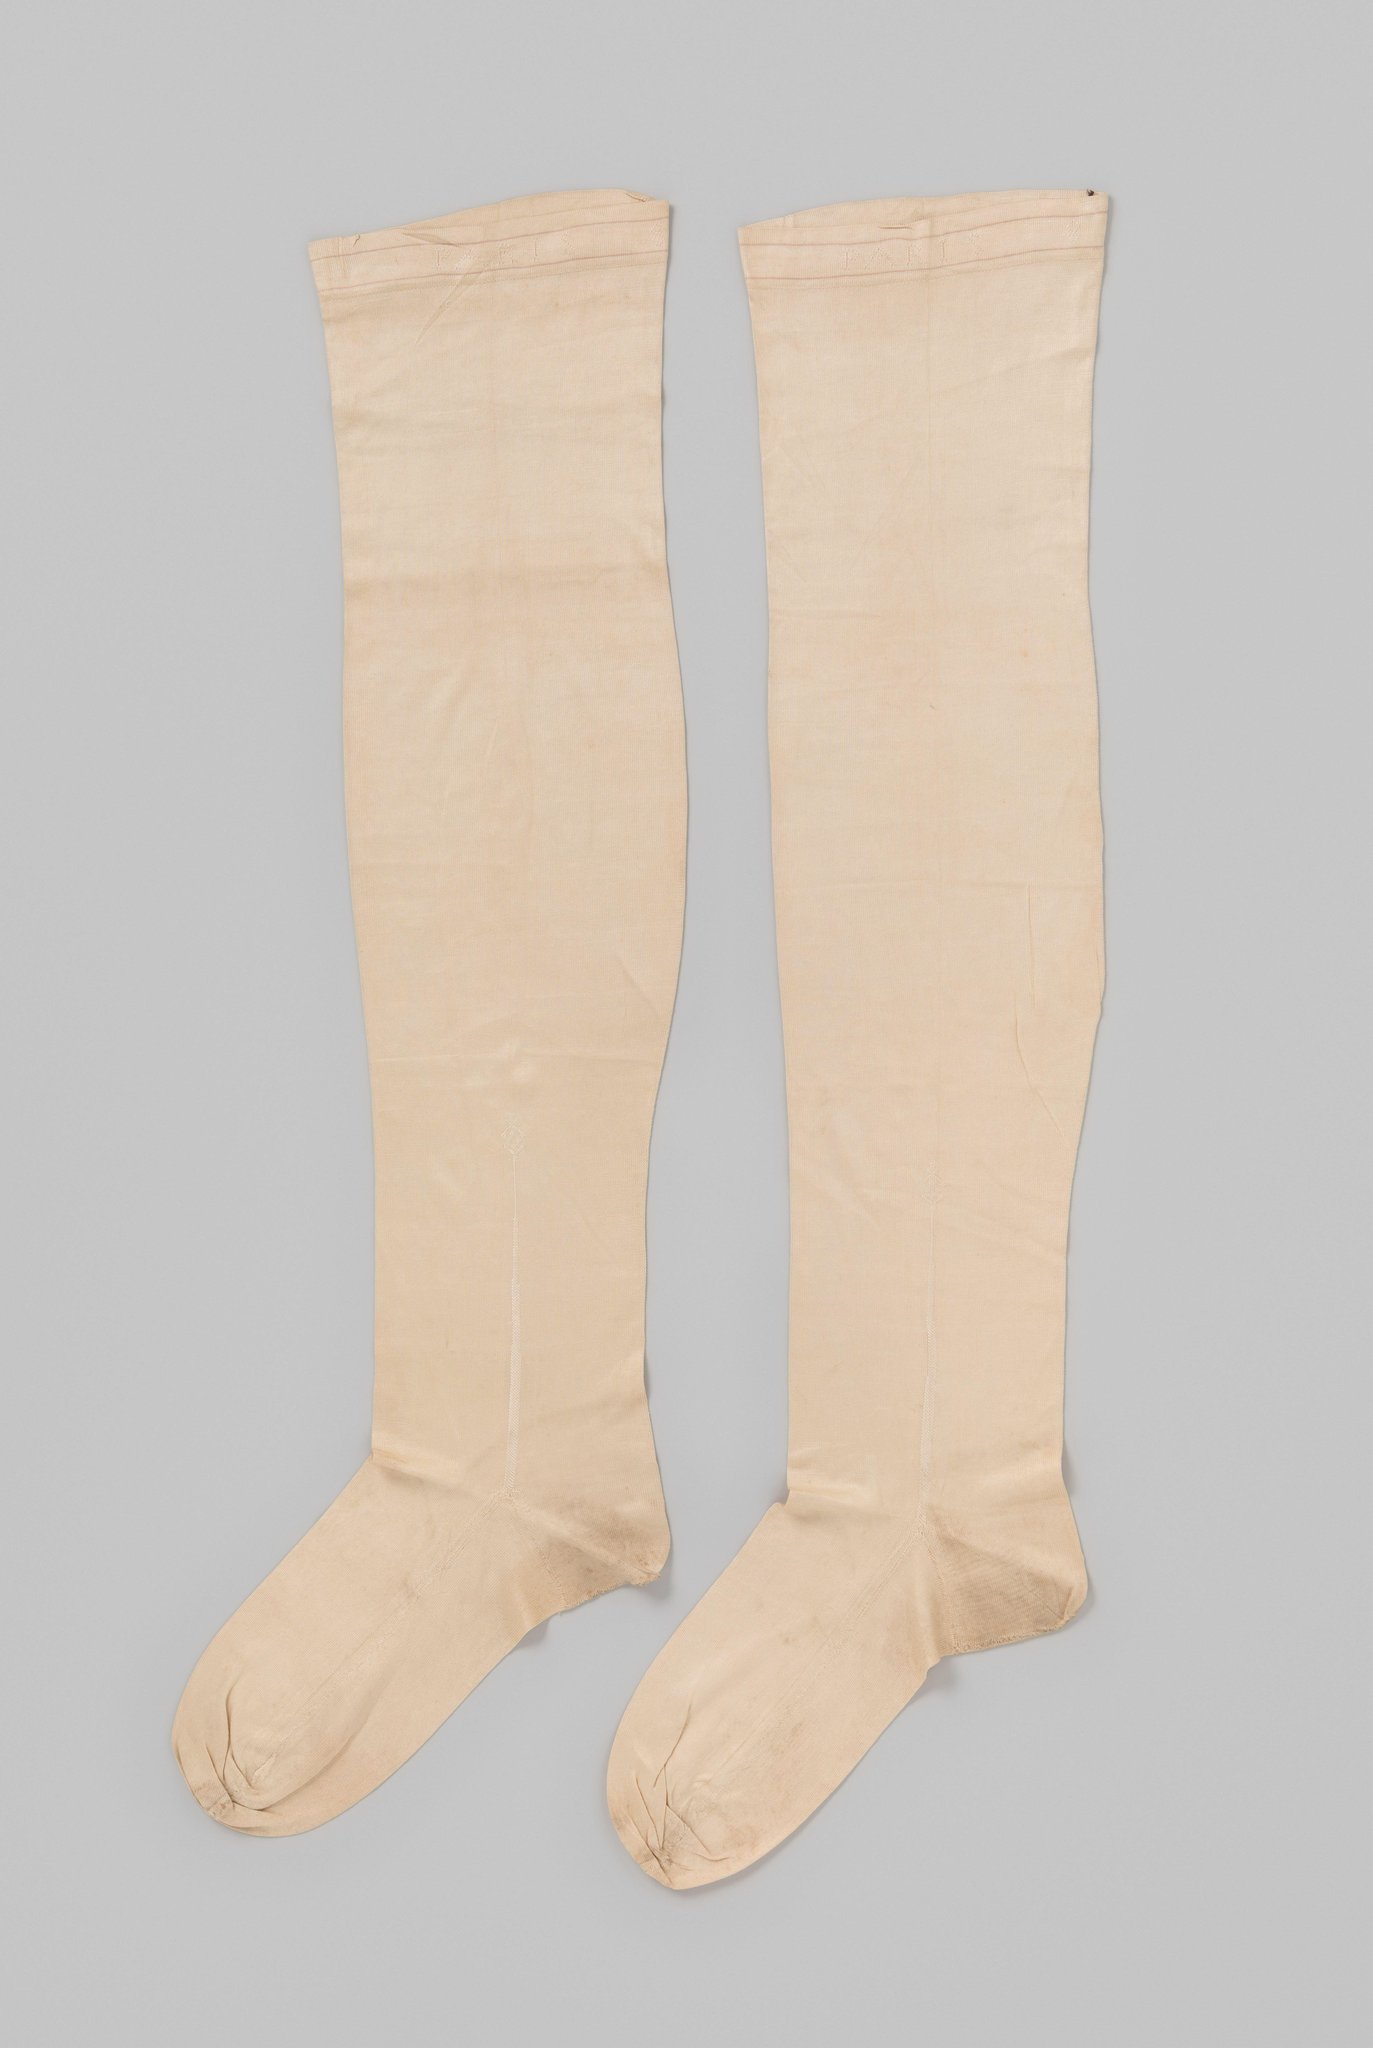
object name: menswear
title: Kous van witte zijde in tricosteek, bovenaan met twee roze smalle strepen en onderaan met twee geborduurde sierlijnen met geometrisch motief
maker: Anonymous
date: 1815-1830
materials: silk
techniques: embroidered, knitting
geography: paris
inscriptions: address: ‘'PARIS 8'’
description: In tricotsteek gebreide kous van witte zijde, bovenaan met twee roze smalle strepen en het merk "Paris 8" en onderaan met twee geborduurde sierlijnen met geometrisch motief.